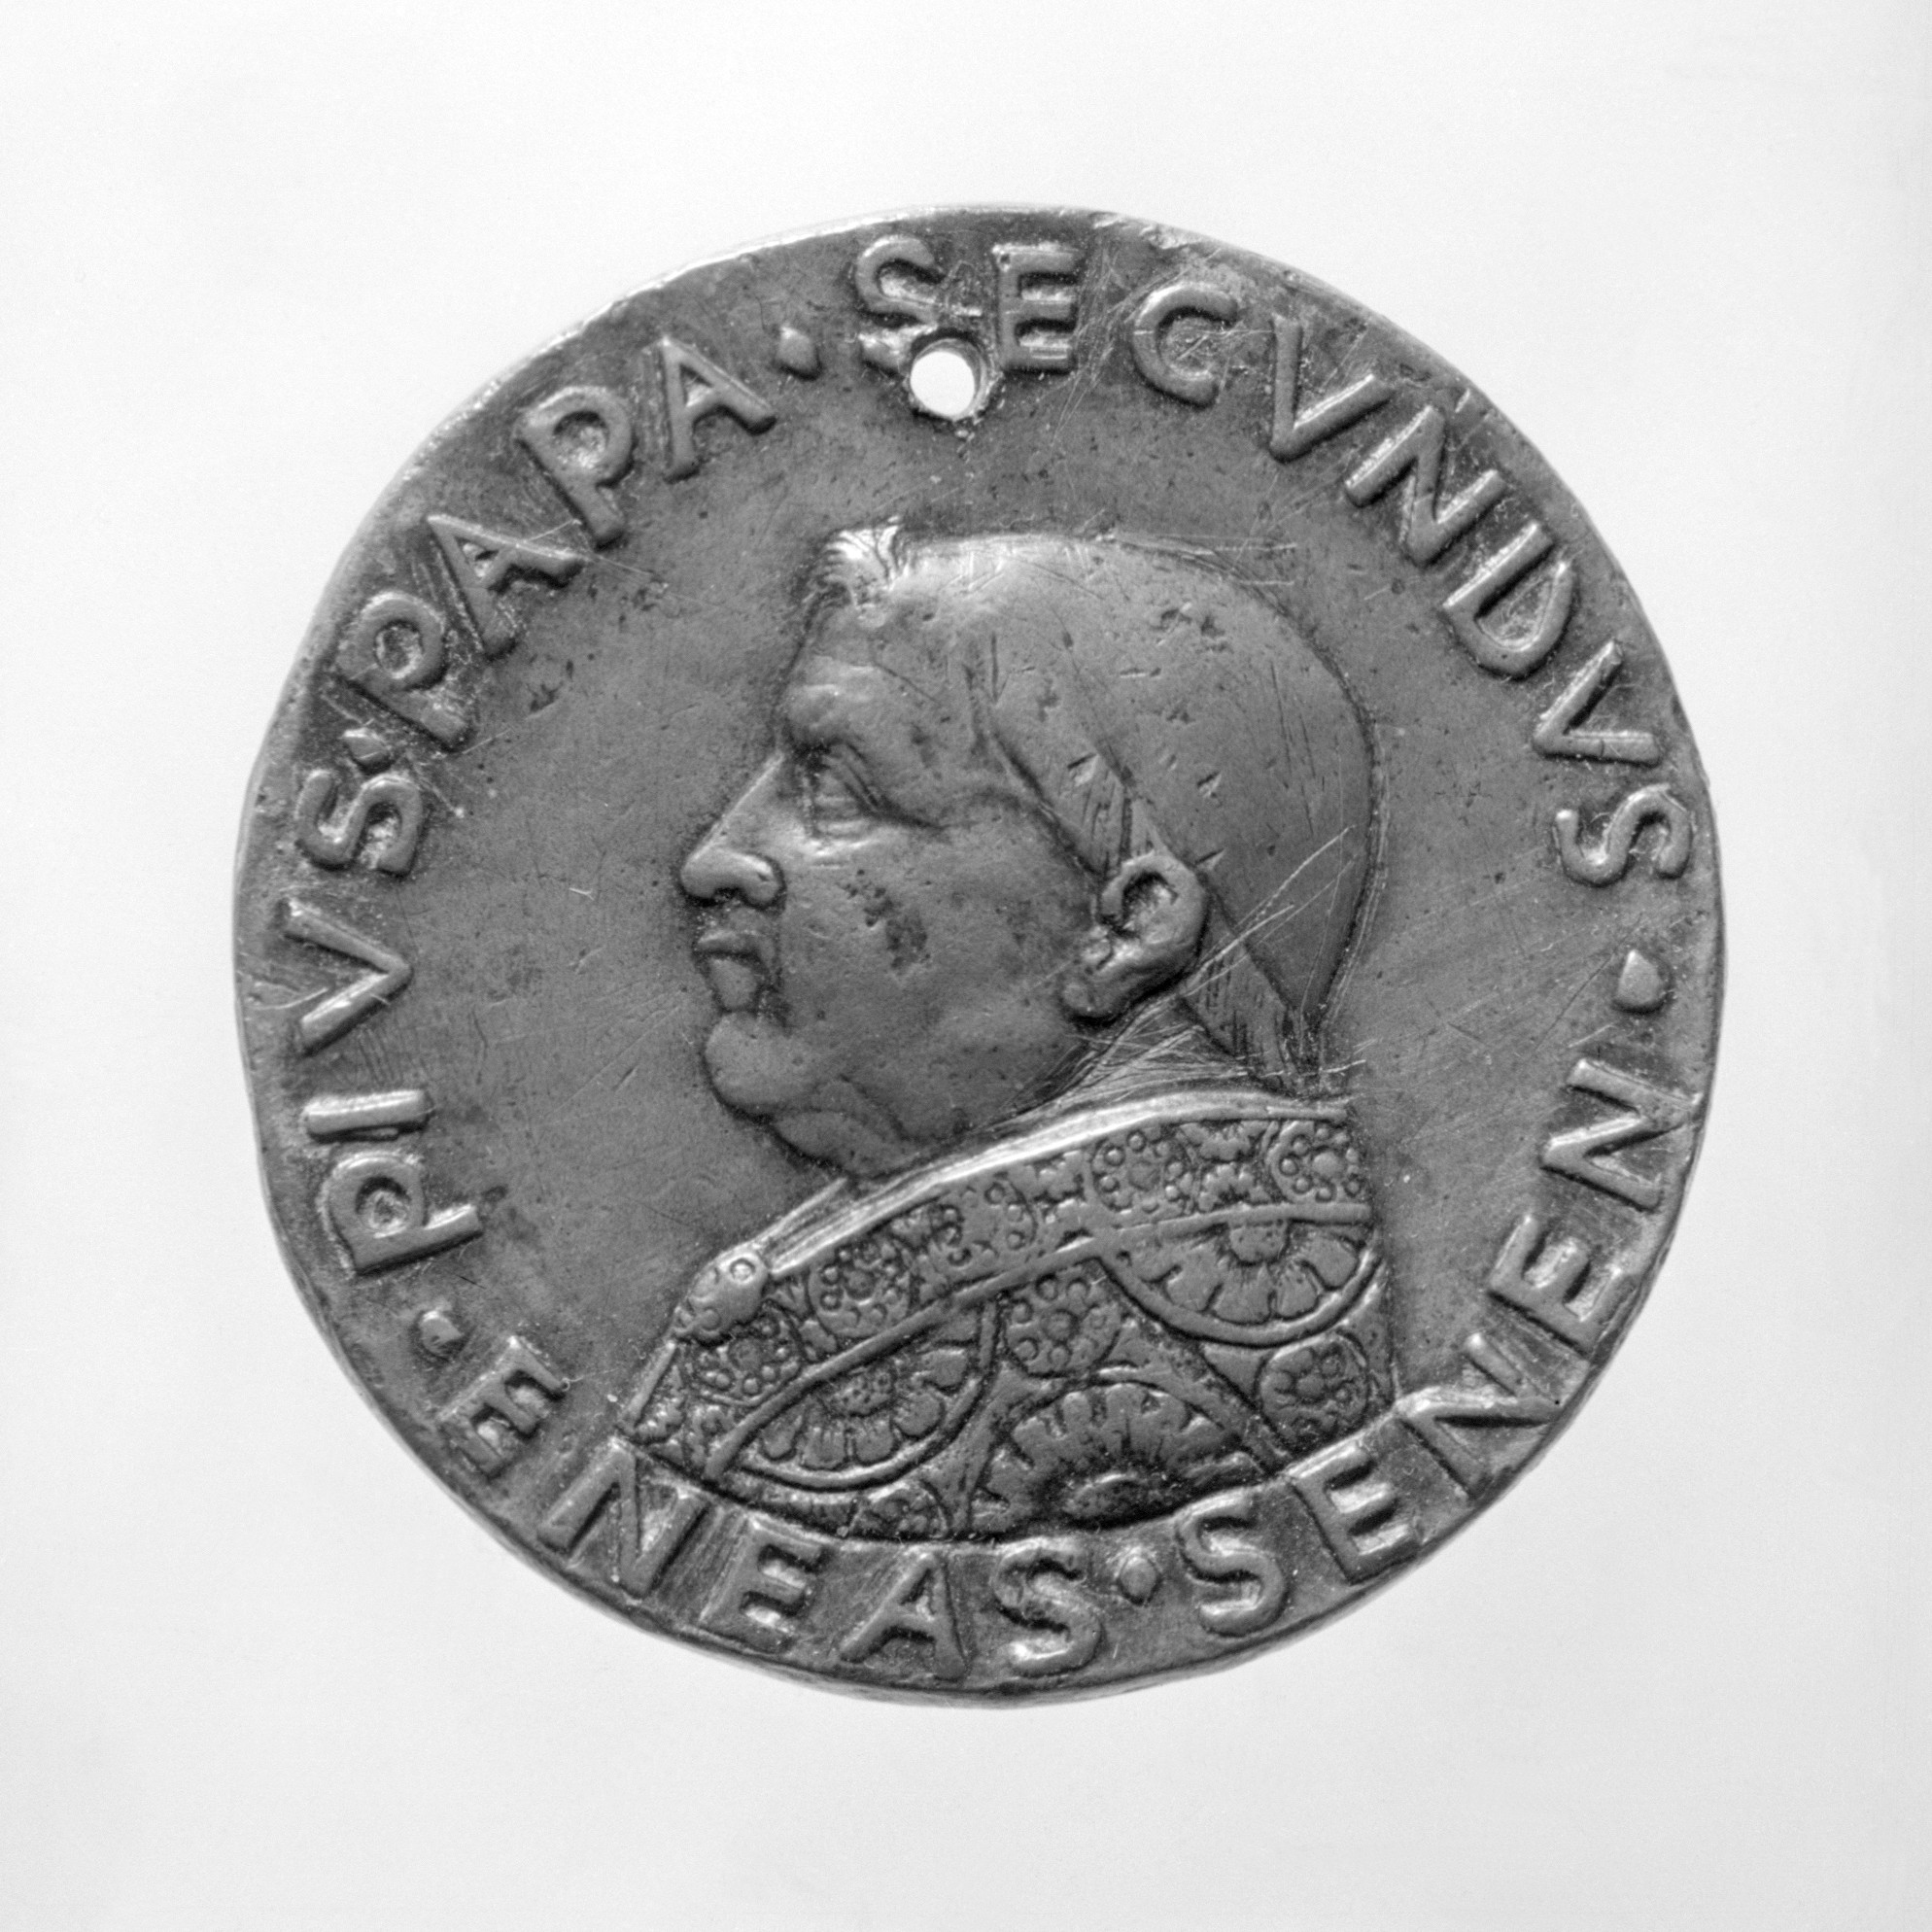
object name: medal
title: Pope Pius II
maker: andrea guazzalotti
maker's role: maker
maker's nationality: italian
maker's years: 1435-1495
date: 1460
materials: bronze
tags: profiles,popes,coat of arms